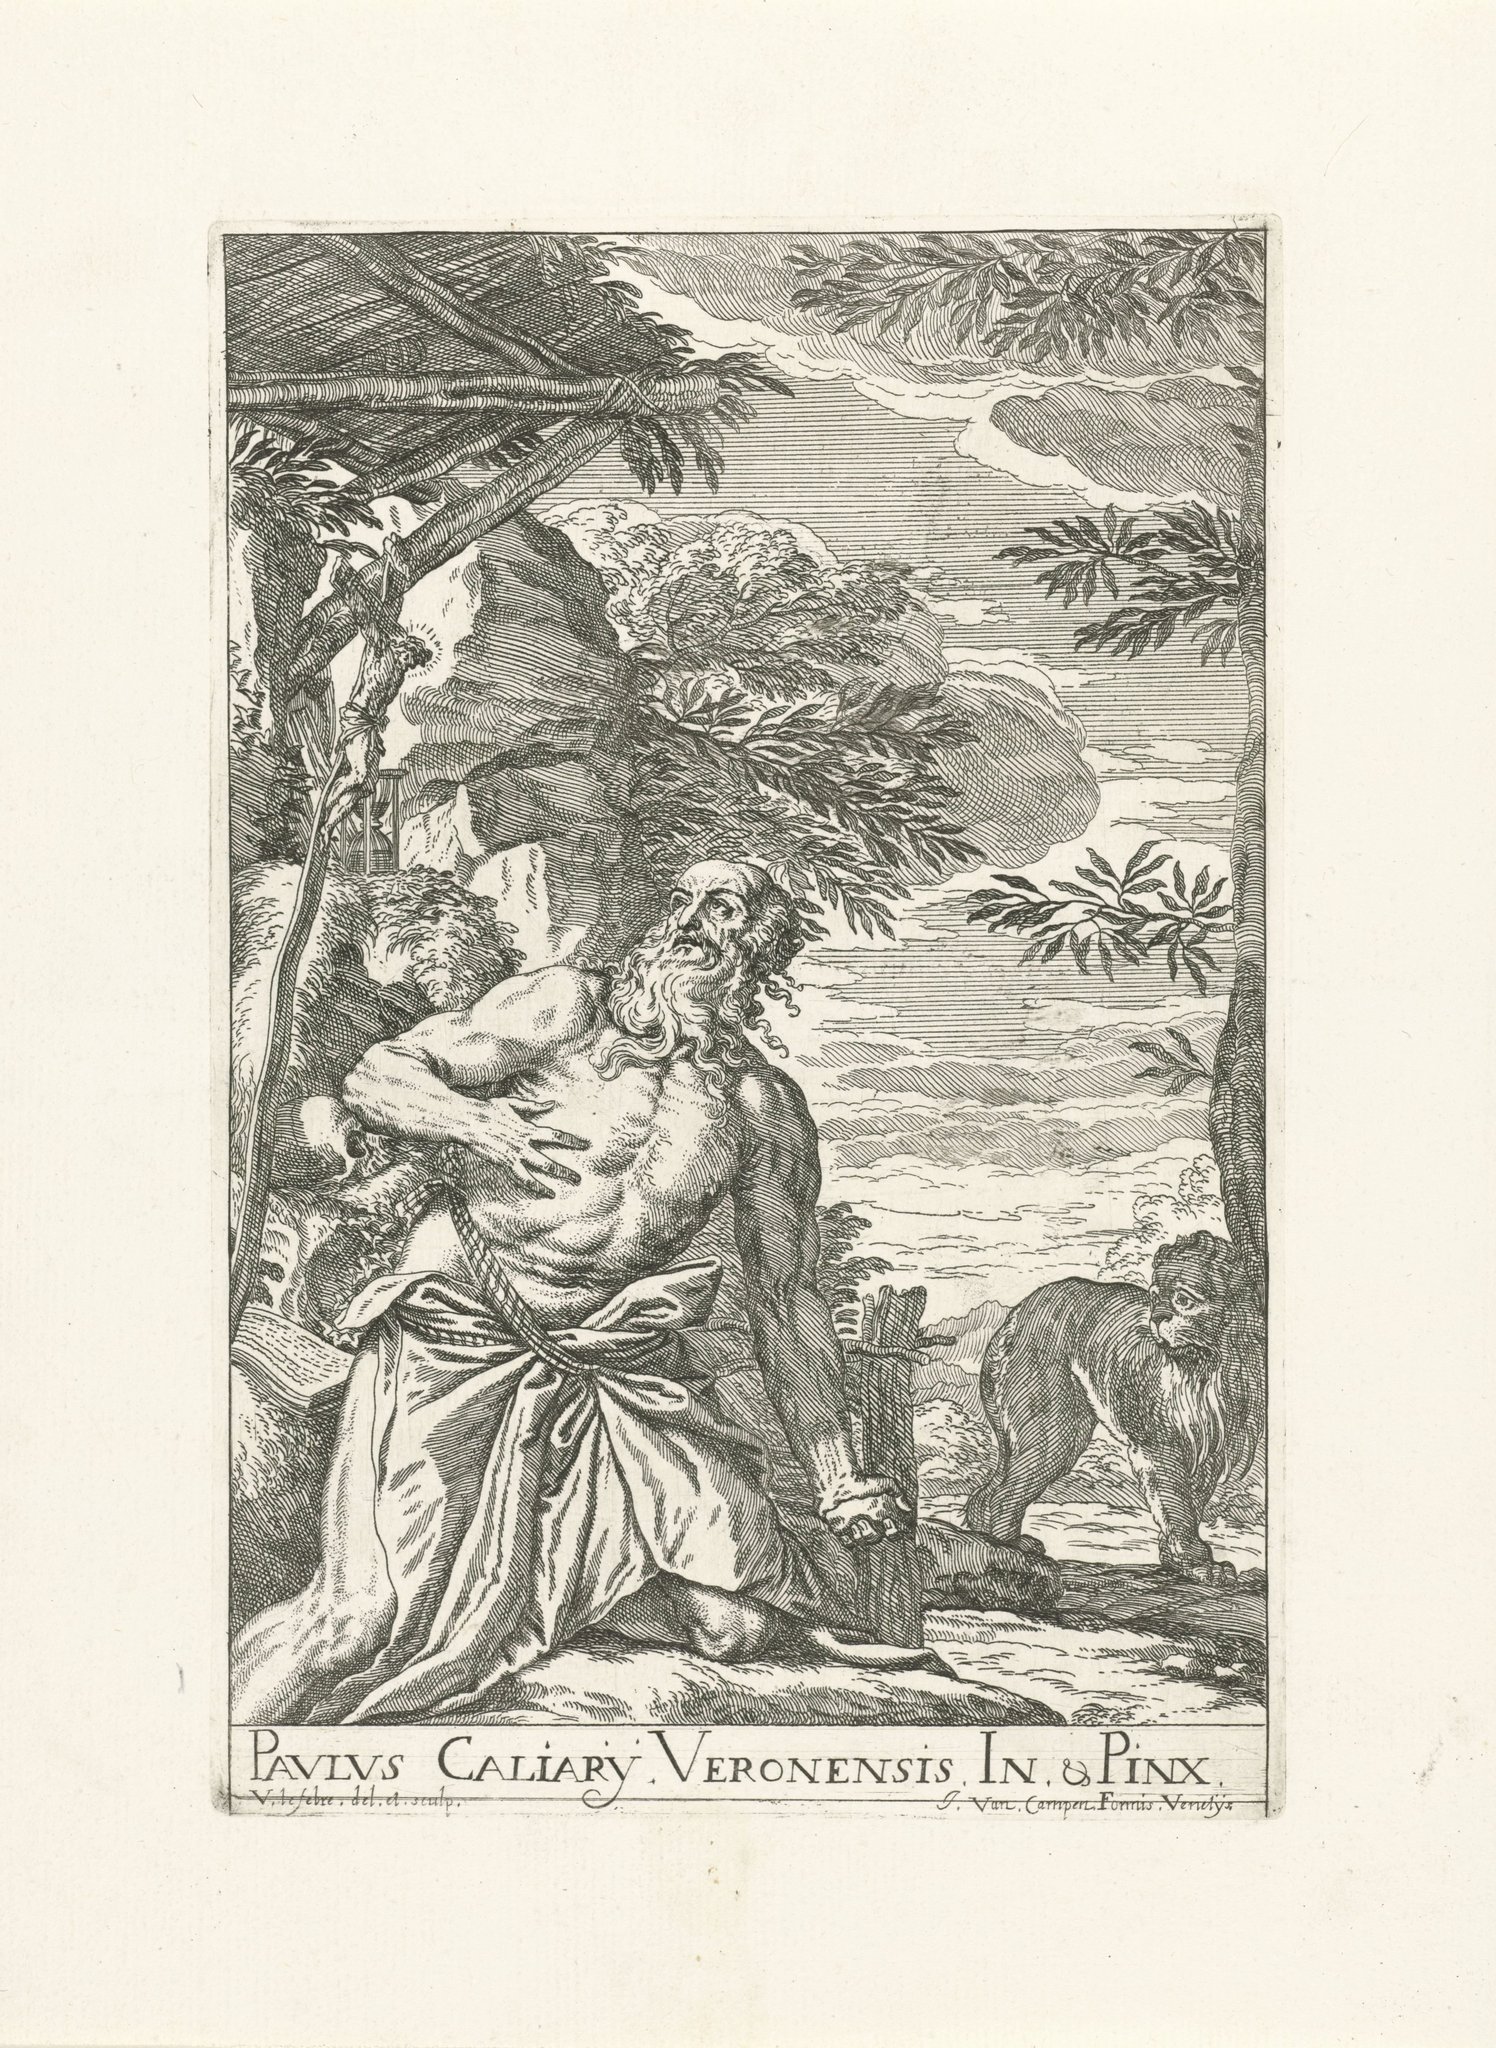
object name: print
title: Opera Selectiora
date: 1682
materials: paper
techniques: etching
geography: venice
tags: st. jerome as penitent in the desert, half naked, kneeling before a crucifix and holding a stone in his hand to beat his breast; a skull (and other 'vanitas' symbols), sometimes a scorpion and a snake beside him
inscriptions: collector's mark: Lugt 2228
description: De heilige Hieronymus is in de wildernis met een steen in zijn handen neergeknield bij een crucifix. Rechts op de achtergrond een leeuw. De prent maakt deel uit van een 53-delige serie prenten naar schilderijen van Titiaan en Veronese.